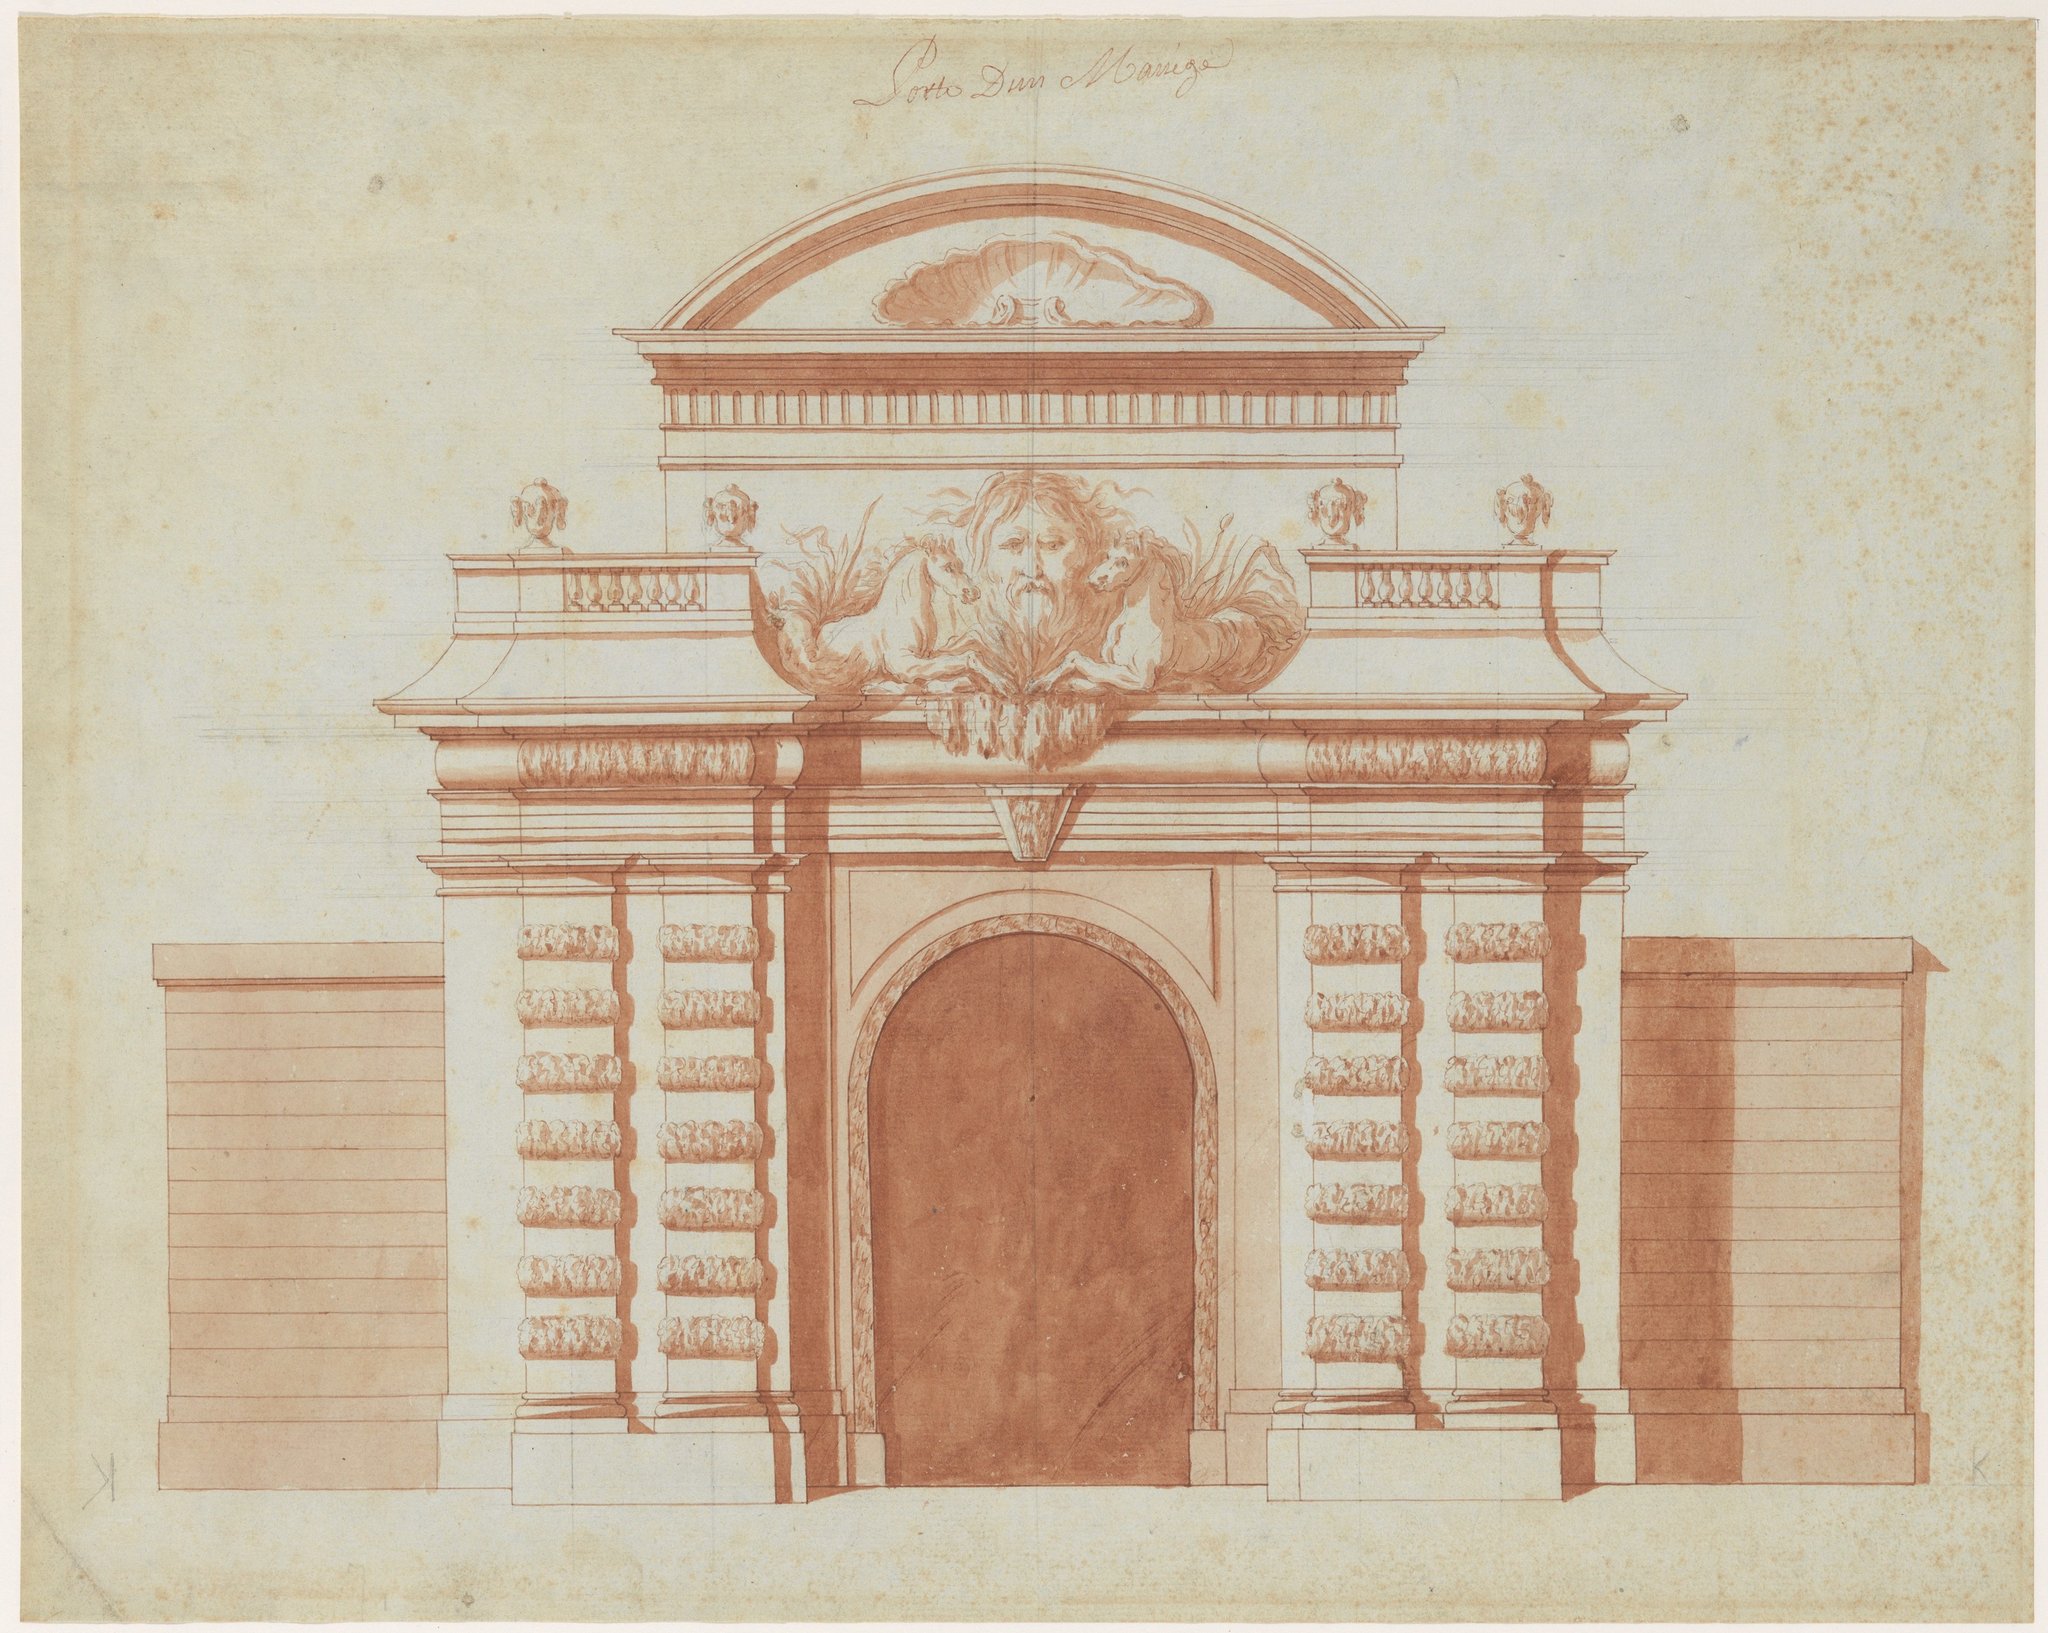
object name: drawing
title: Elevation of an Entrance to a Riding School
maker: anonymous, french, 18th century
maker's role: artist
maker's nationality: french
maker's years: 1700-1800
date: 1701-1800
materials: graphite, ink, paper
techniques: brush, incising, pen, drawing, wash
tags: architecture